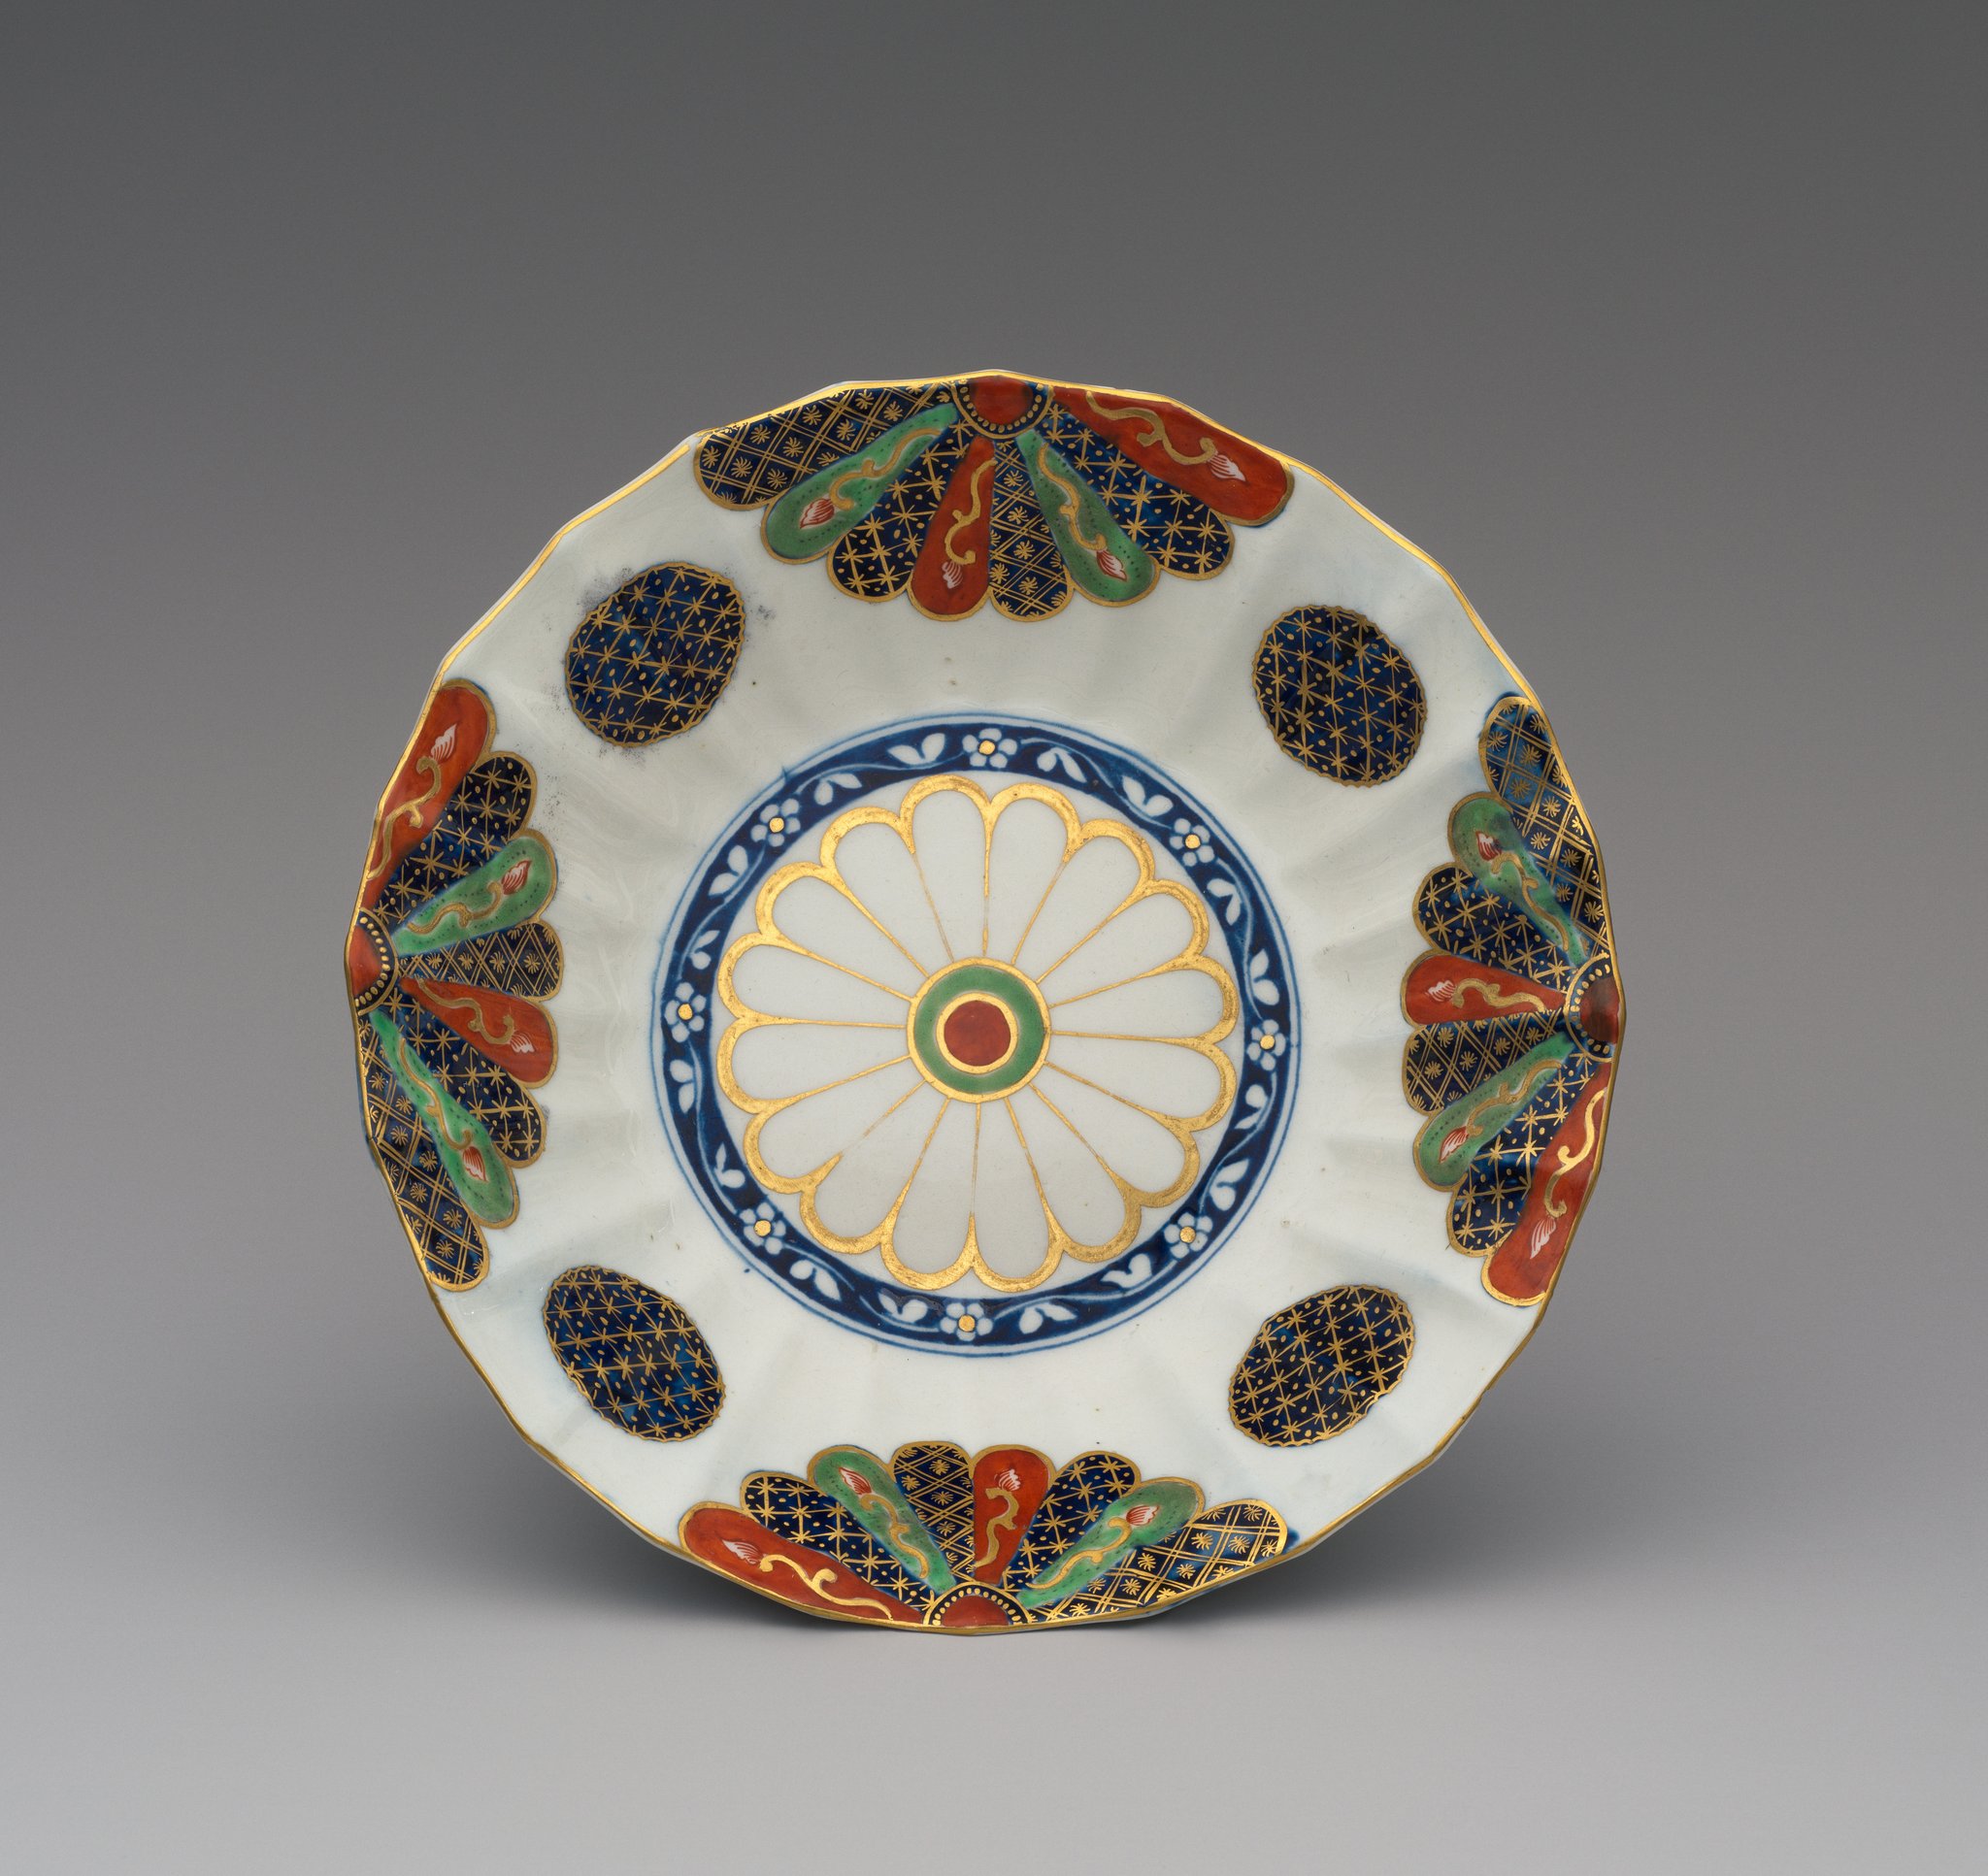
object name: dish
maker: worcester factory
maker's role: factory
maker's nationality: british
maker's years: 1751-2008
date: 1770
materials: soft paste porcelain